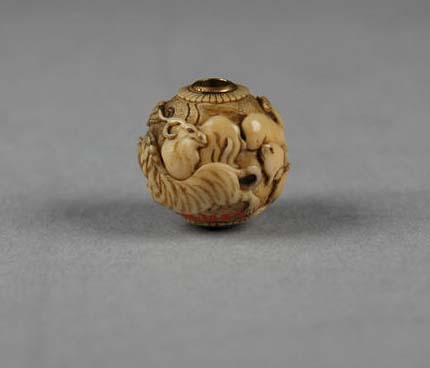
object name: bead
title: Carved Bead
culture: japanese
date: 1801-1900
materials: ivory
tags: animals